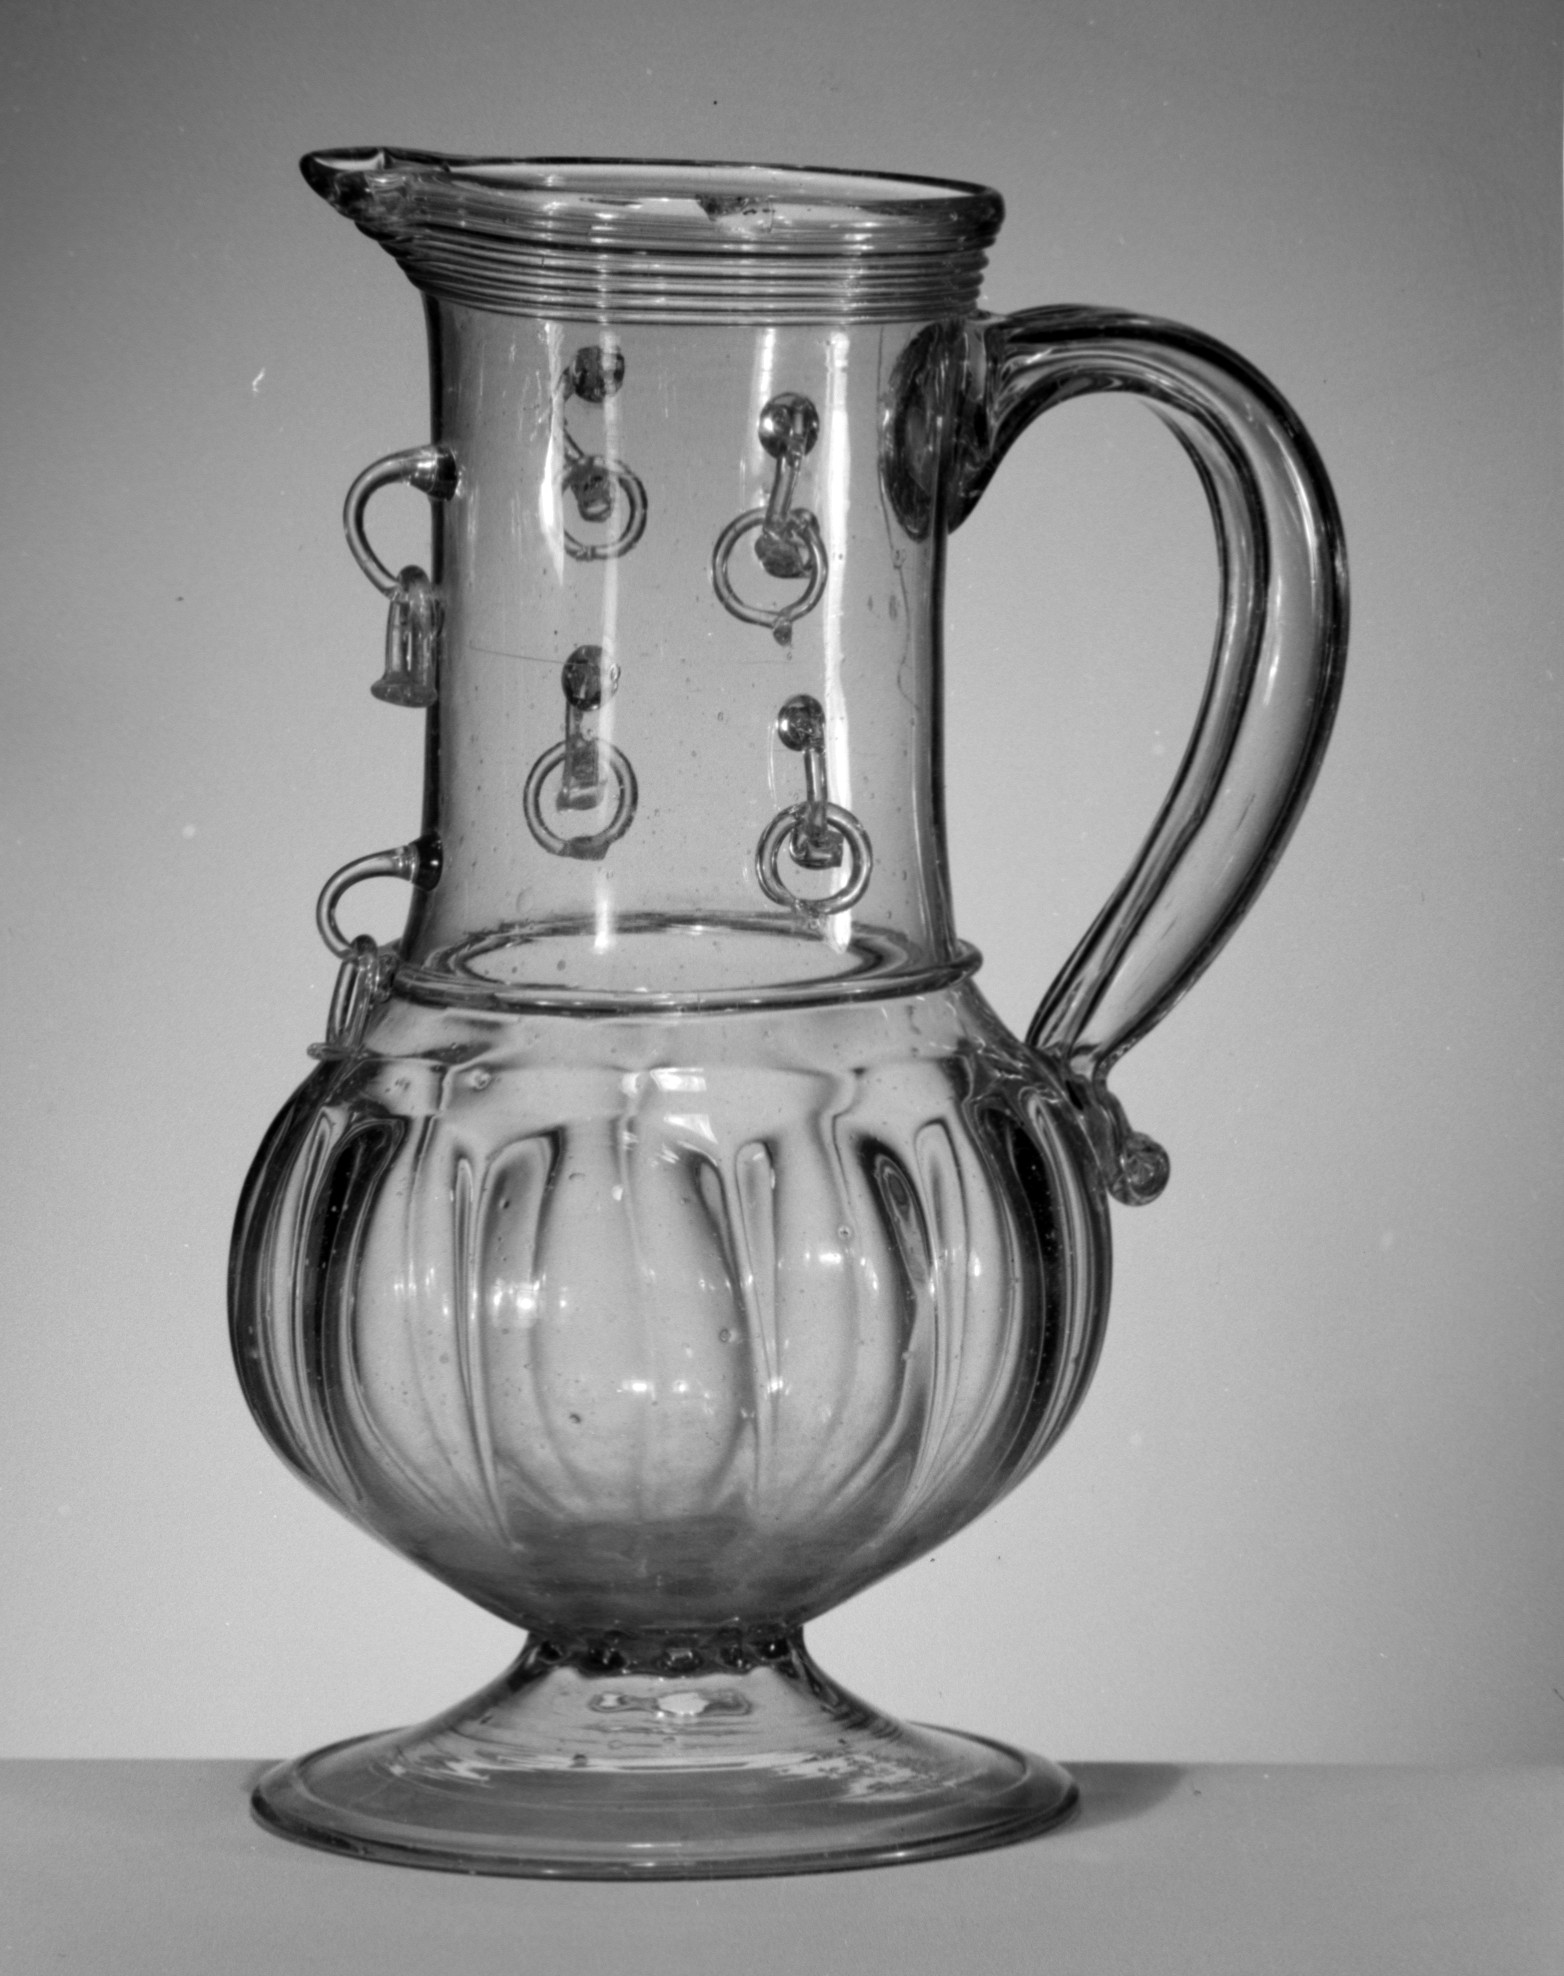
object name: jug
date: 1701-1800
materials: glass